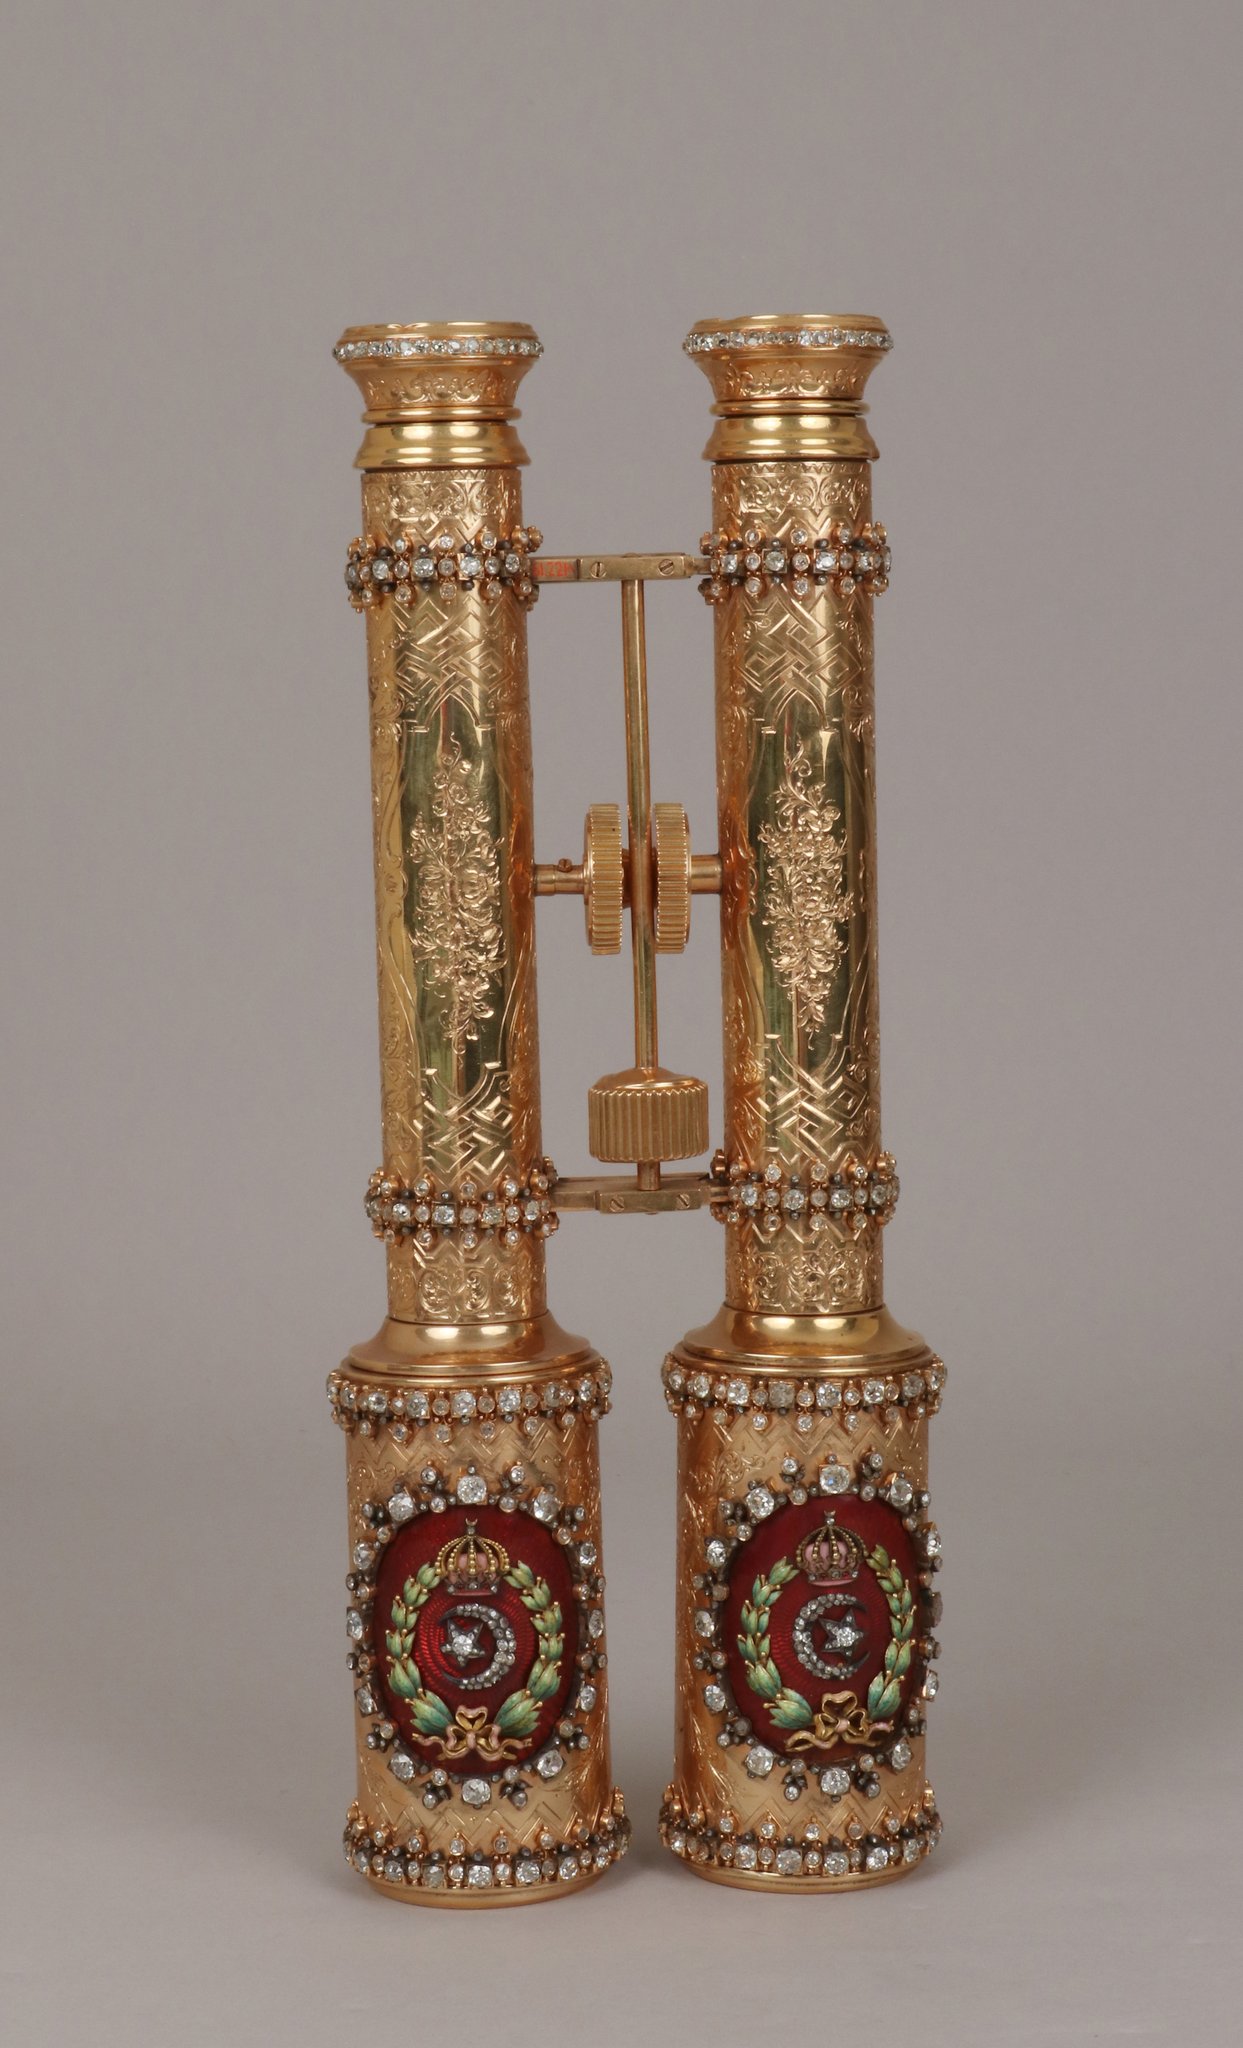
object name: field glass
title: Field glasses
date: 1851-1900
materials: diamond, enamel, gold